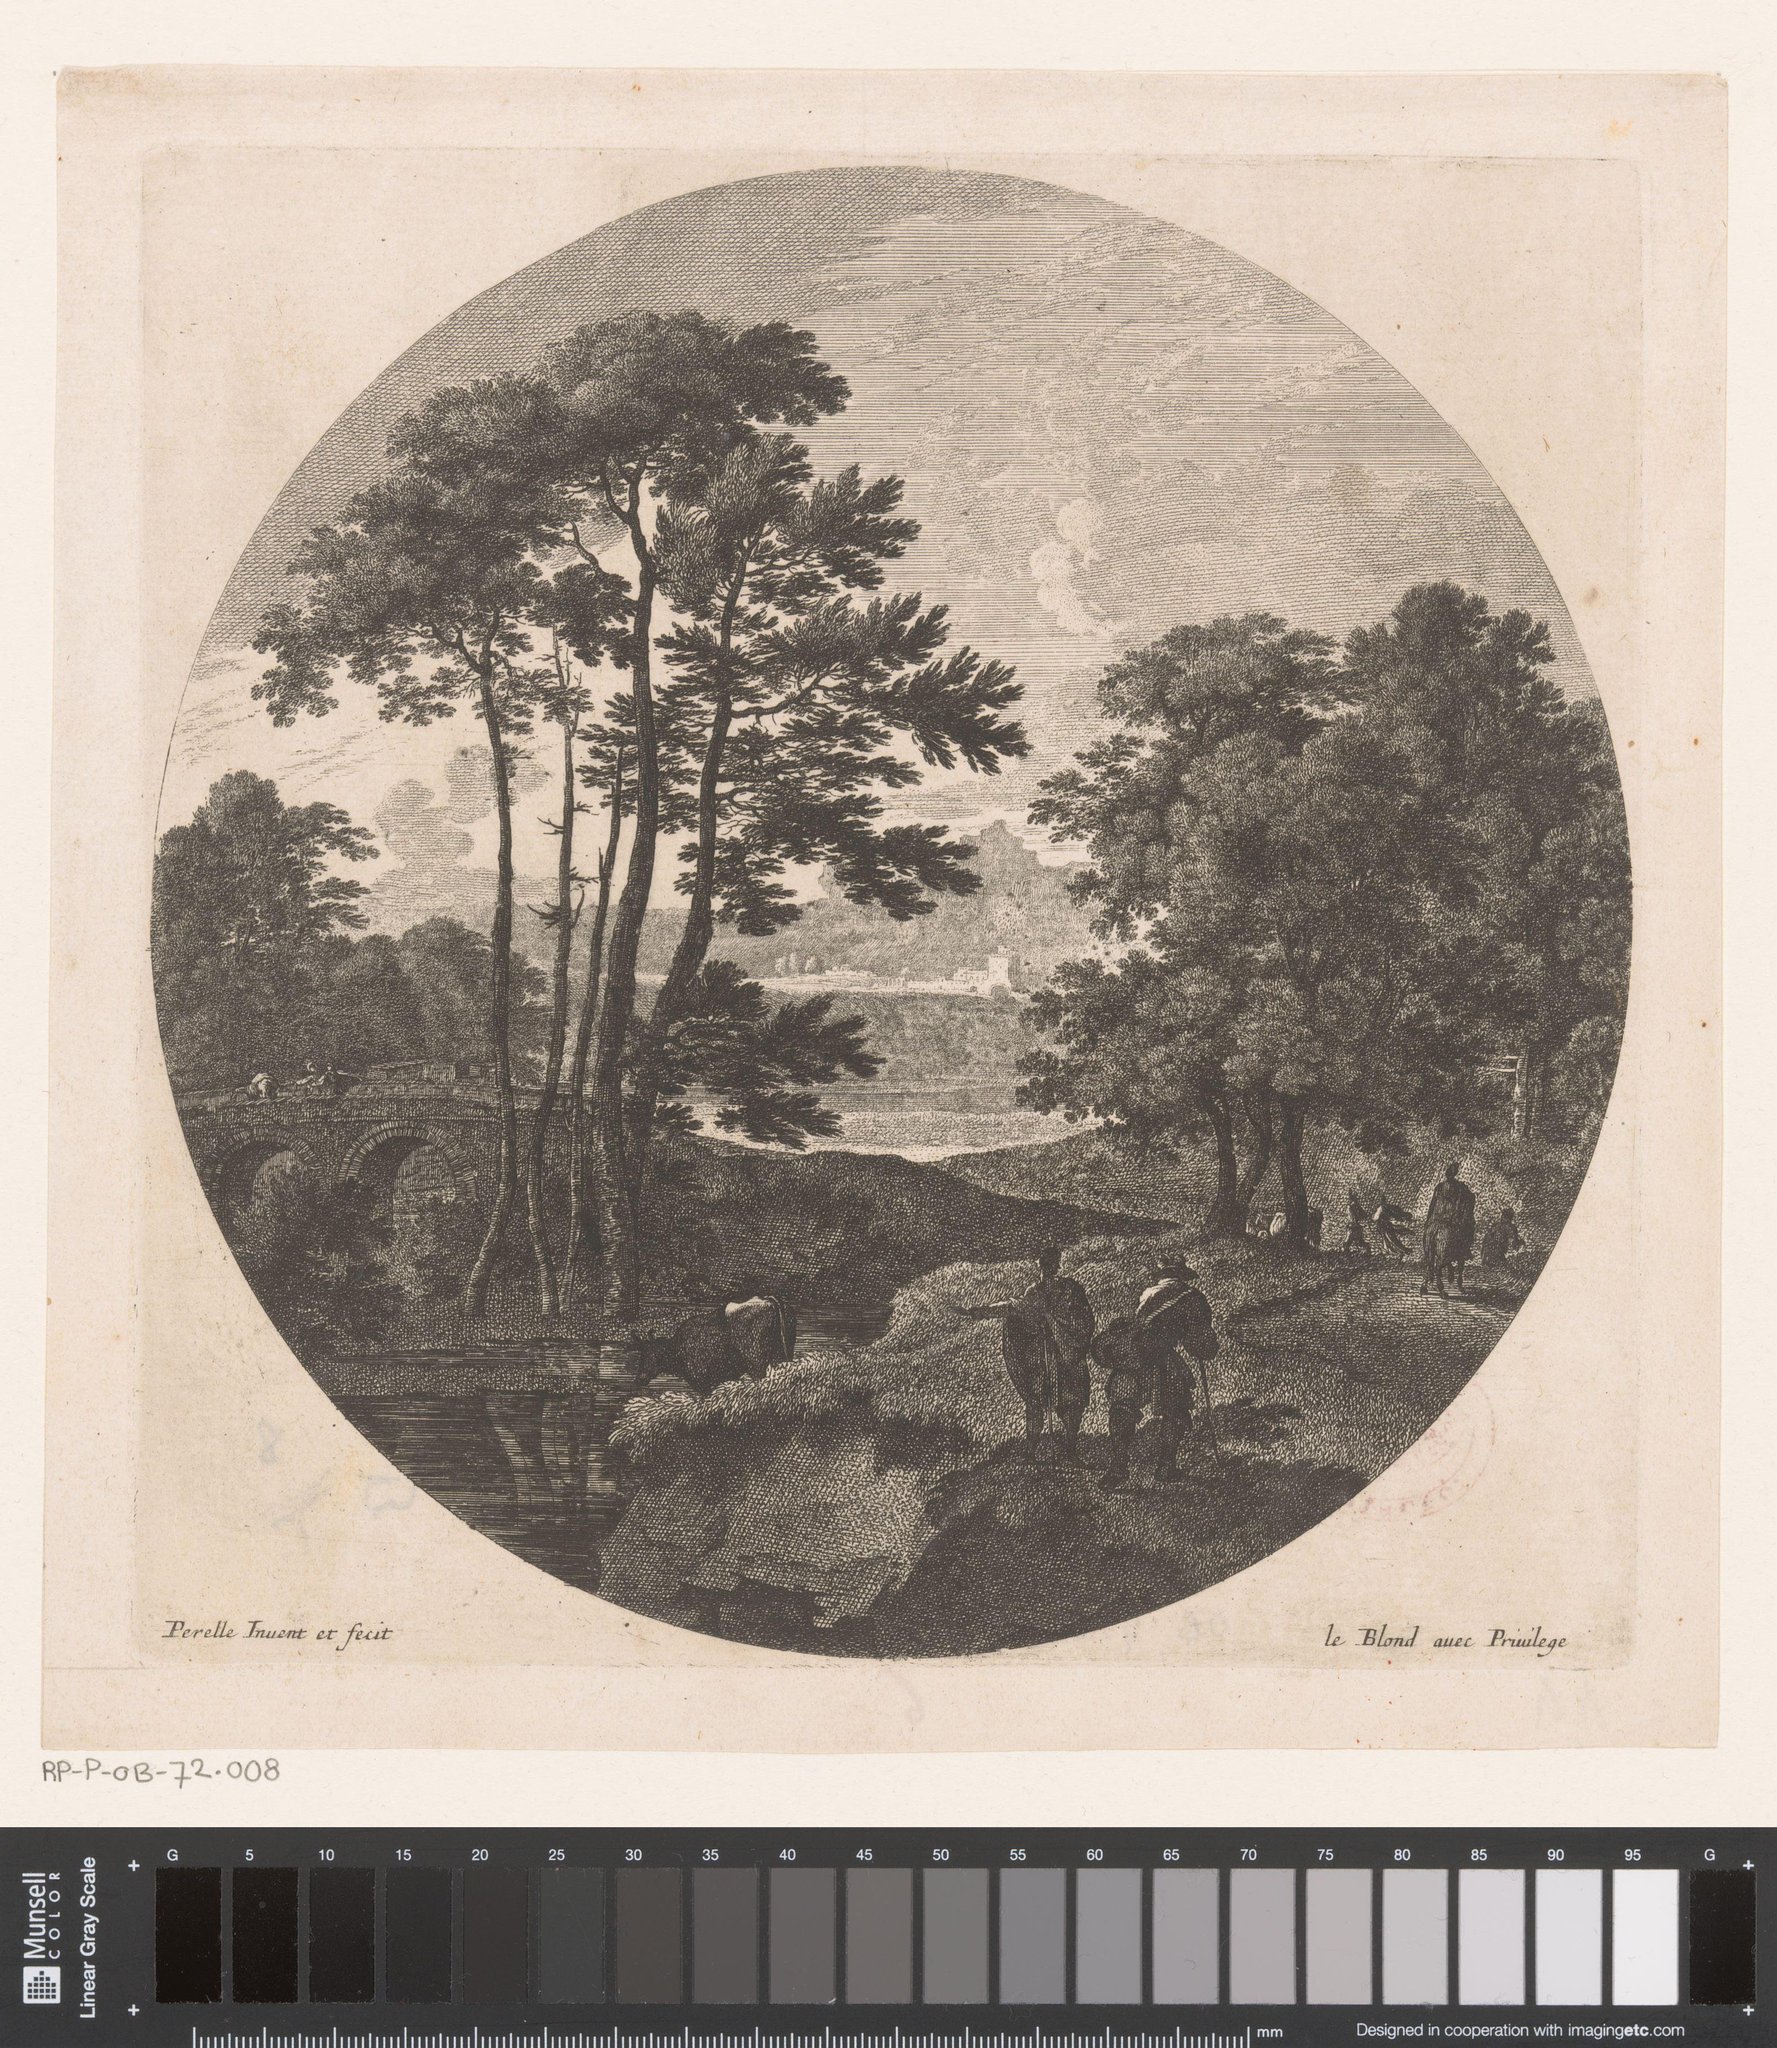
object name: print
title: Landschap met figuren bij stenen brug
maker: jean leblond (i)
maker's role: publisher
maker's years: 1590-1666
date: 1620-1666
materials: paper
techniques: etching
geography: france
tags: landscape with bridge, viaduct or aqueduct (+ city(-scape) with figures, staffage)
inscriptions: collector's mark: Lugt 240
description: Prenten met het signatuur 'Perelle' kunnen zowel door vader Gabriel als door zonen Nicolas en Adam gemaakt zijn.